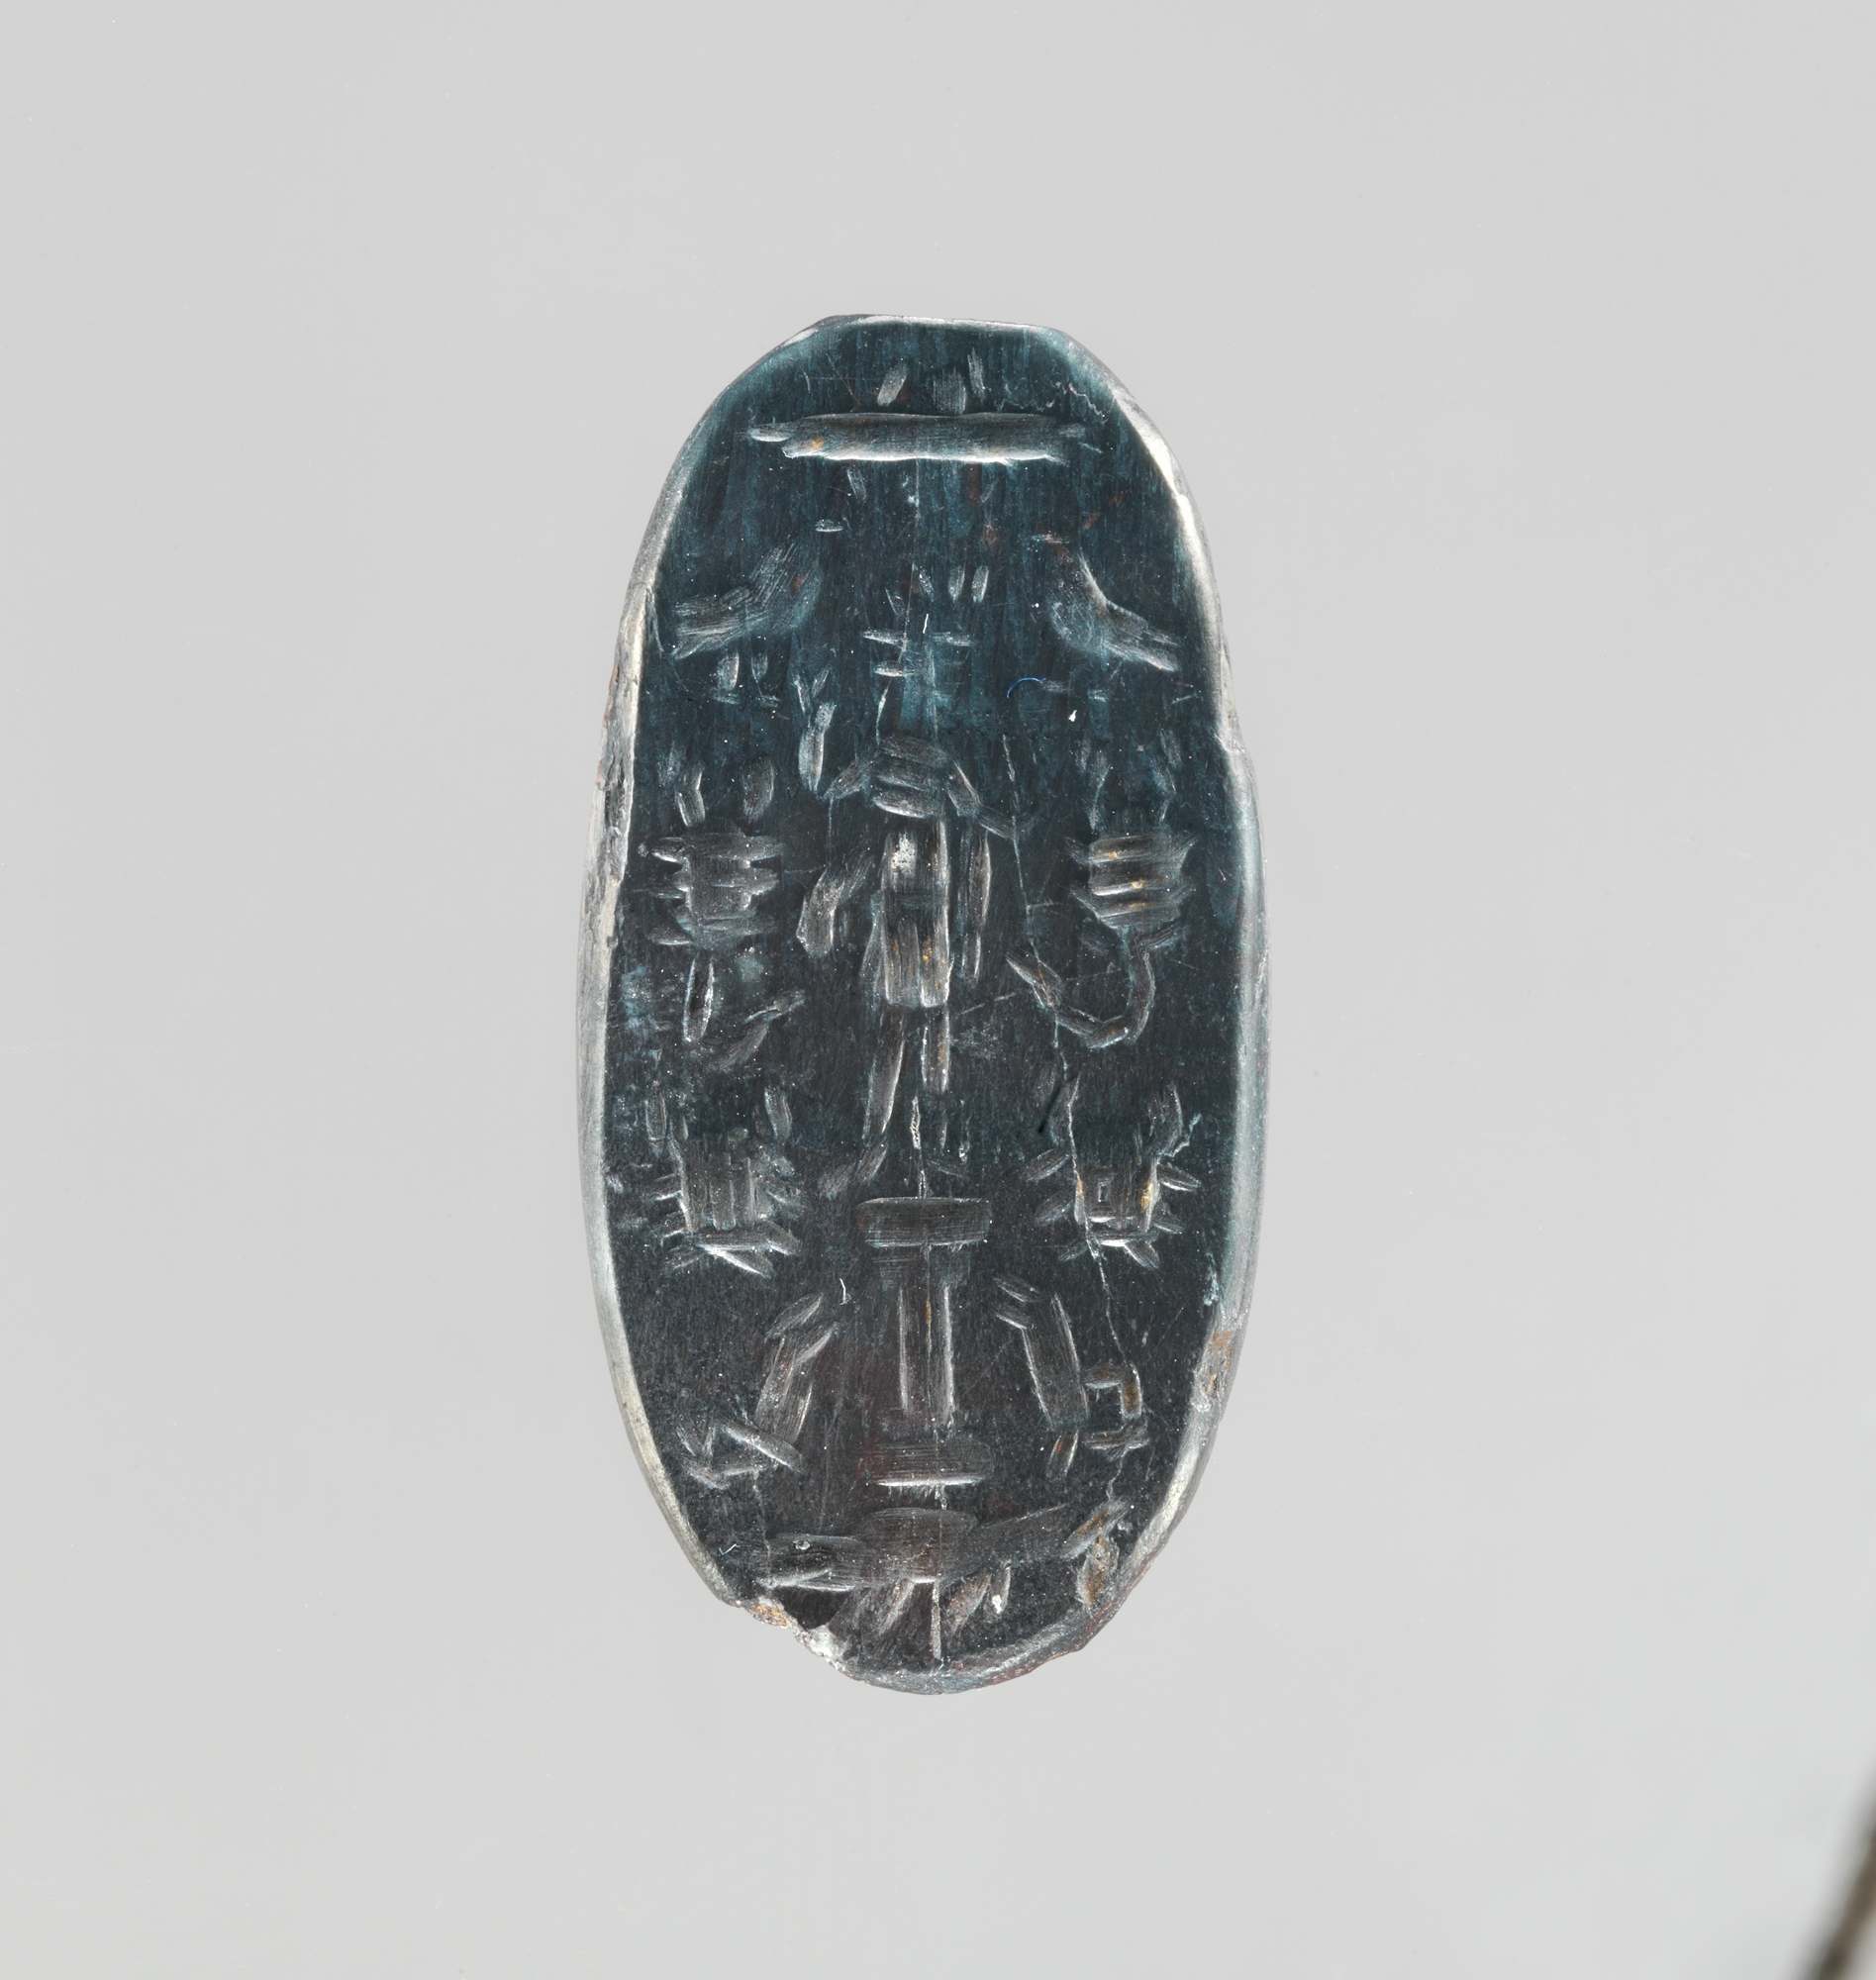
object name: intaglio, magical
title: Hematite intaglio: Lion-headed god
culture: roman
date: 101-300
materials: mineral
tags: birds,scorpions